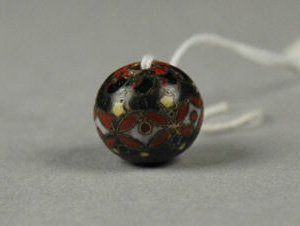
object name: ojime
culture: japanese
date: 1801-1900